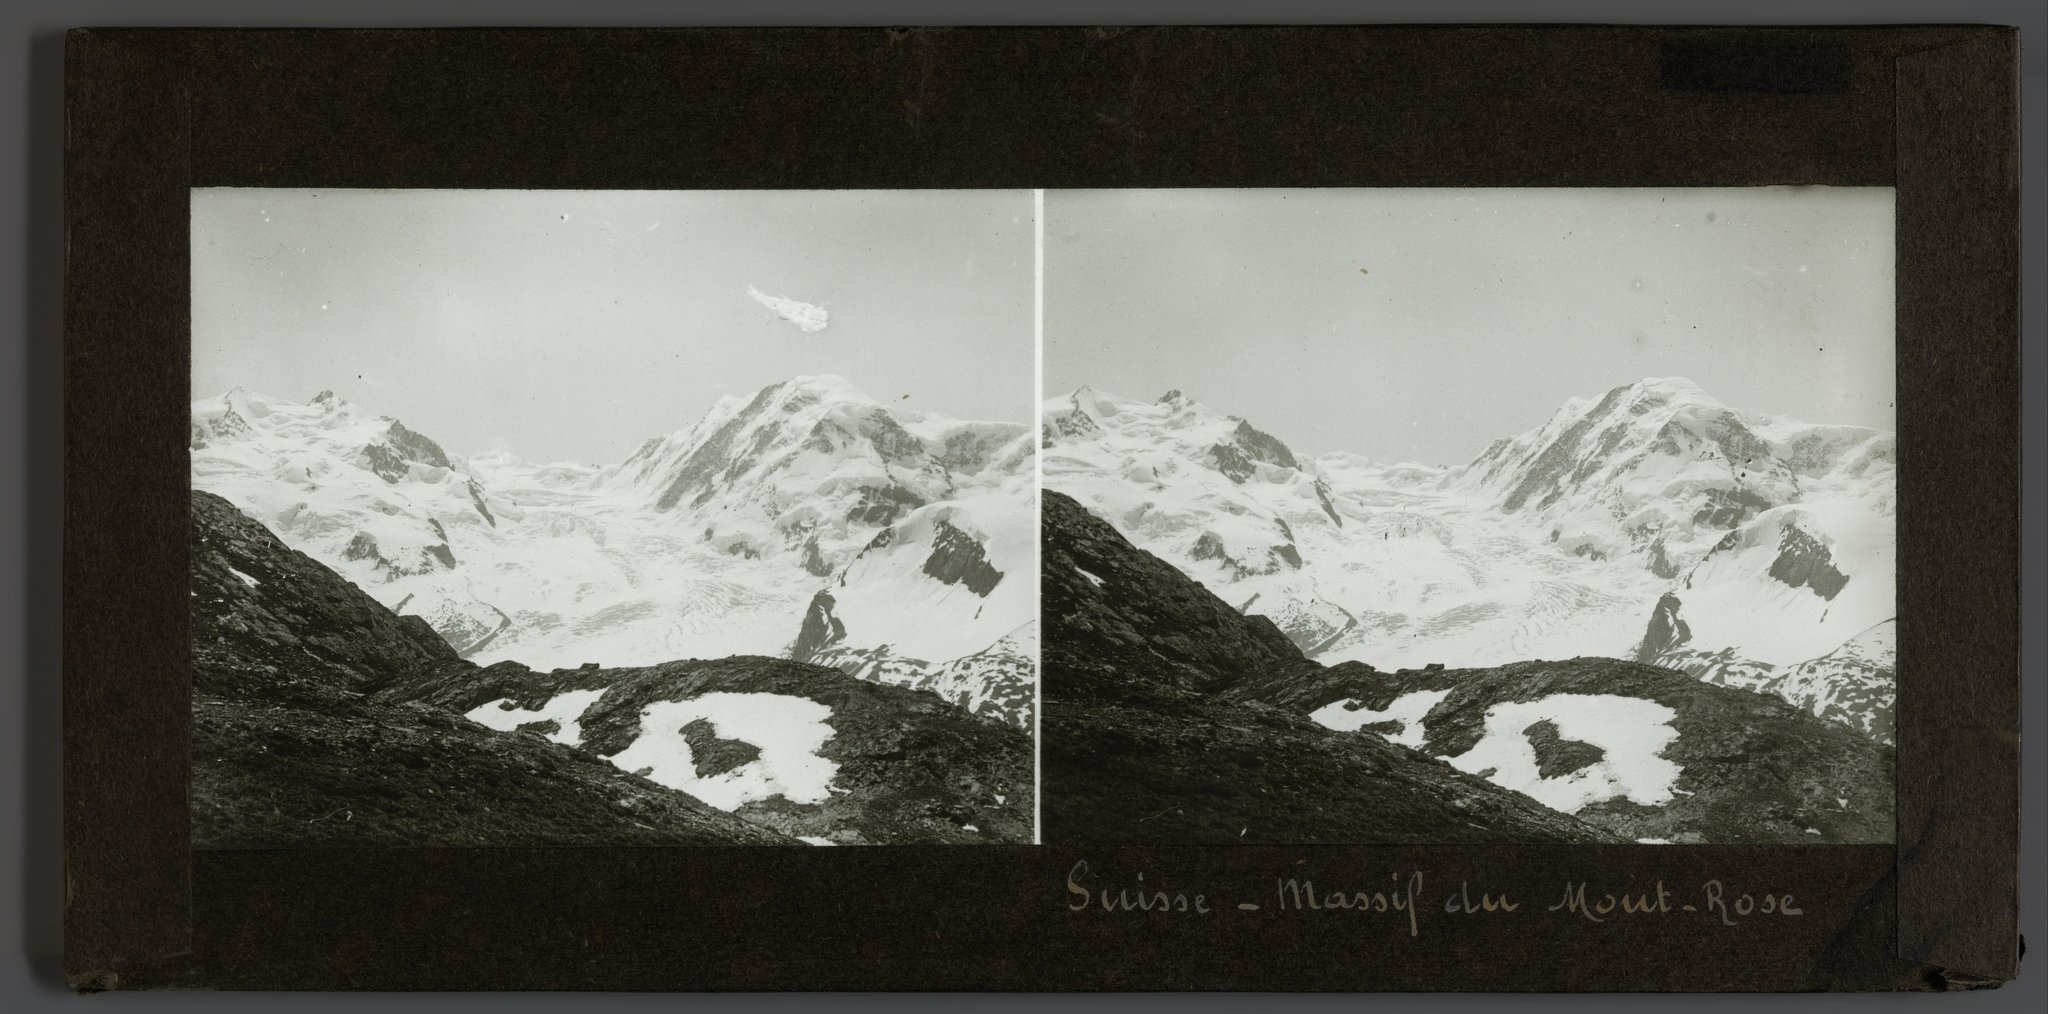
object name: stereoscopic photograph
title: Gezicht op het massief van de Monte Rosa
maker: Anonymous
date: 1860-1900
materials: glass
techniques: slide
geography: switzerland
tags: mountains